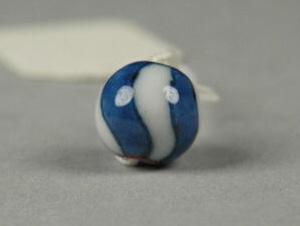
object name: ojime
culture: japanese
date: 1801-1900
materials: porcelain